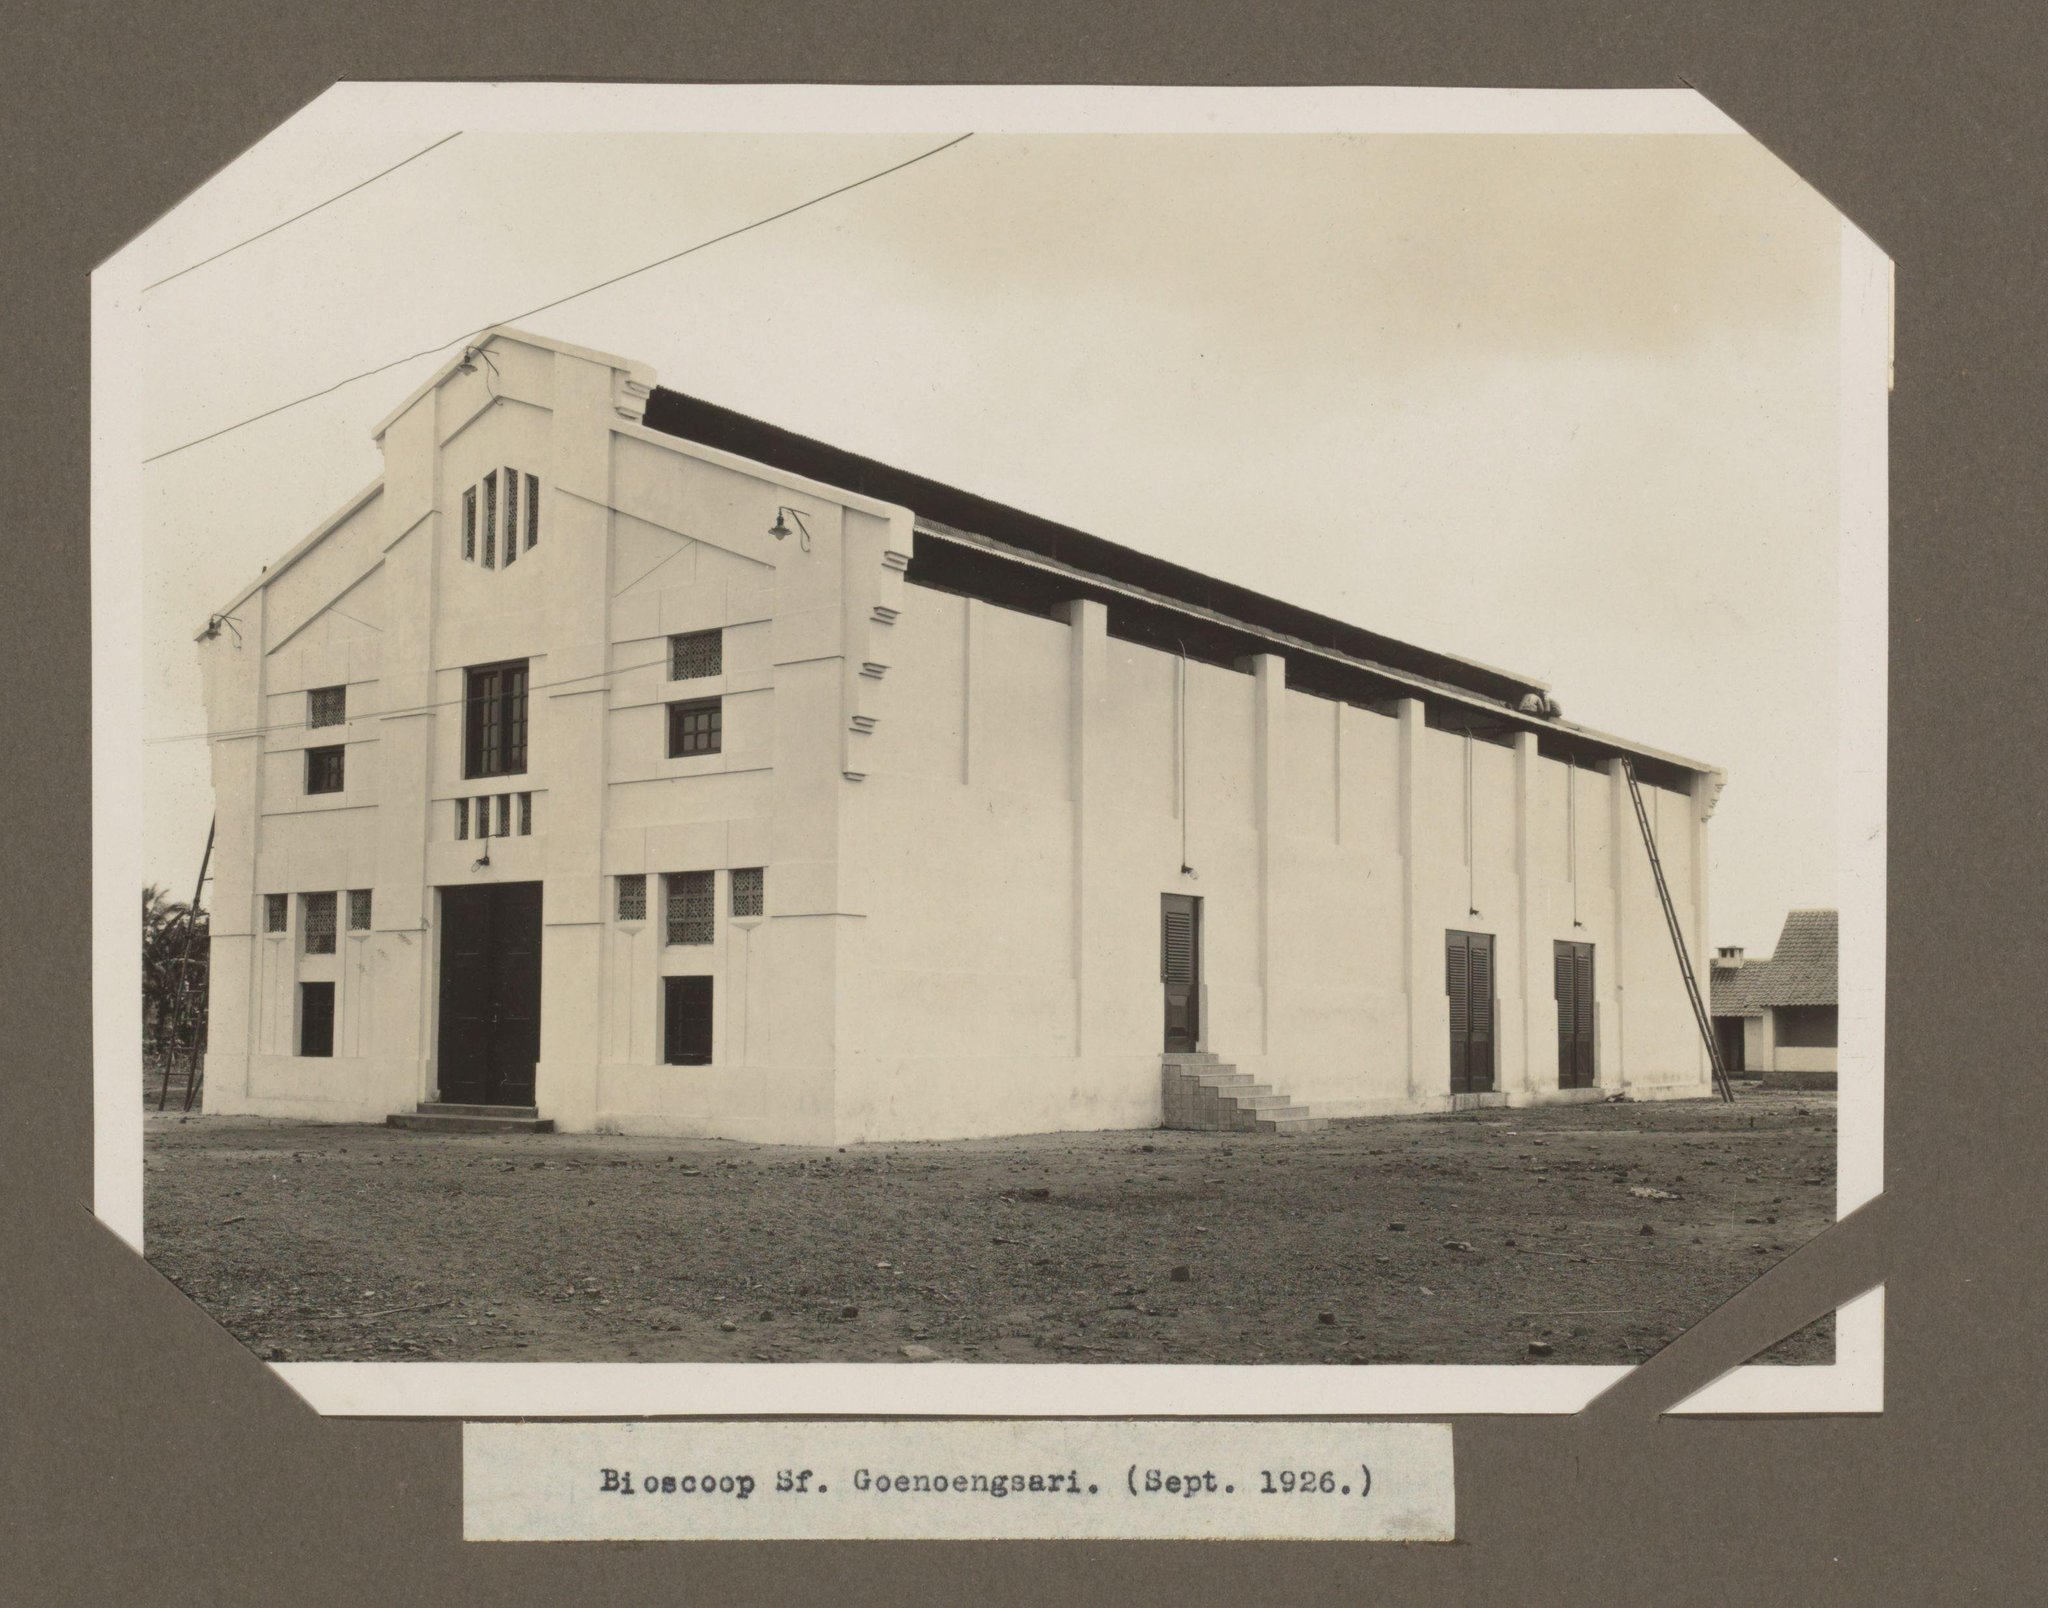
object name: photograph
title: Bioscoop Sf. Goenoengsari. (Sept. 1926.)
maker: Anonymous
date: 1909-1926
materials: photographic support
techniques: gelatin silver print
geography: east java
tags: colonial system, trade-company, cinema, movie-house, (non-fruit) products of plants or trees: sugarcane, representation of real building (either existing or having existed)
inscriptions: inscription: ‘Bioscoop Sf. Goenoengsari. (Sept. 1926.)’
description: De bioscoop gebouwd op het fabrieksterrein, september 1926. Onderdeel van het fotoalbum met foto's van de opbouw van de suikerfabriek te Goenoengsari op Oost-Java door de Handels Vereniging Amsterdam 1926-1927.